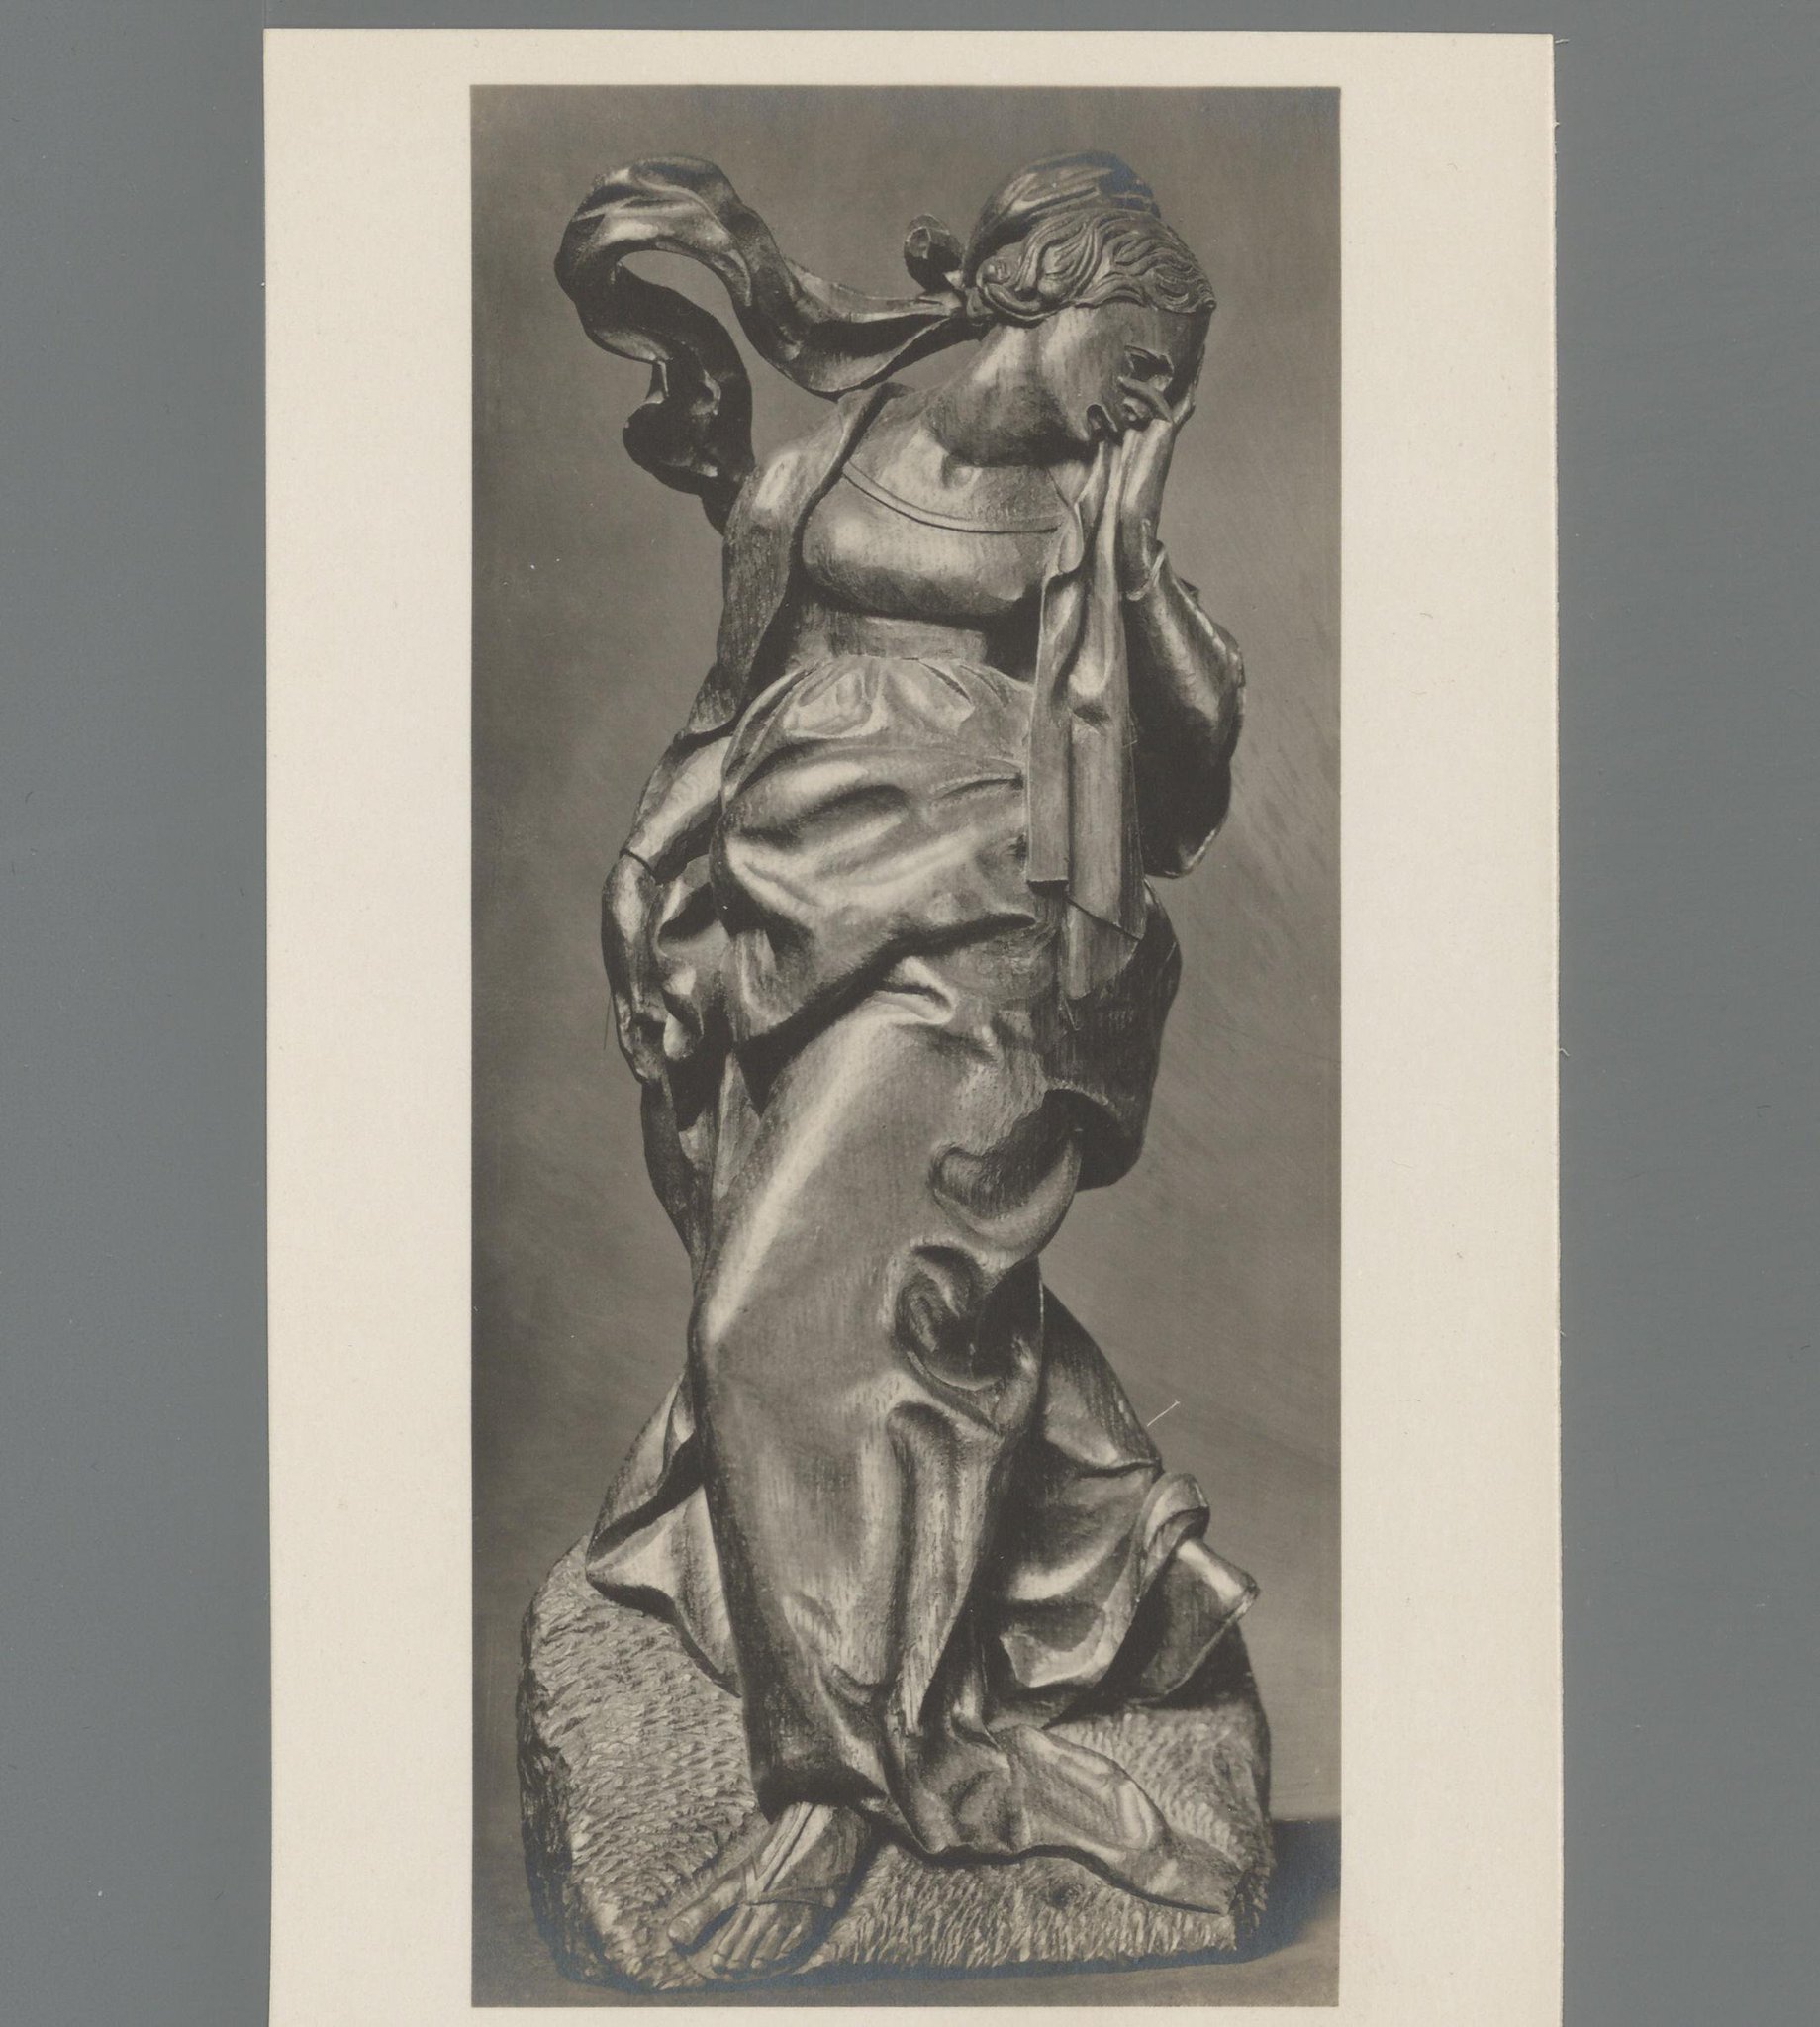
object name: photograph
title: Kaiser-Friedrich-Museum Berlin. Klagende Frau aus einer Beweinung Christi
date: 1904-1930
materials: photographic support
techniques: photography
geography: berlin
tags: statues, paintings, etc. ~ objects of worship in roman religion, permanent exhibition, museum